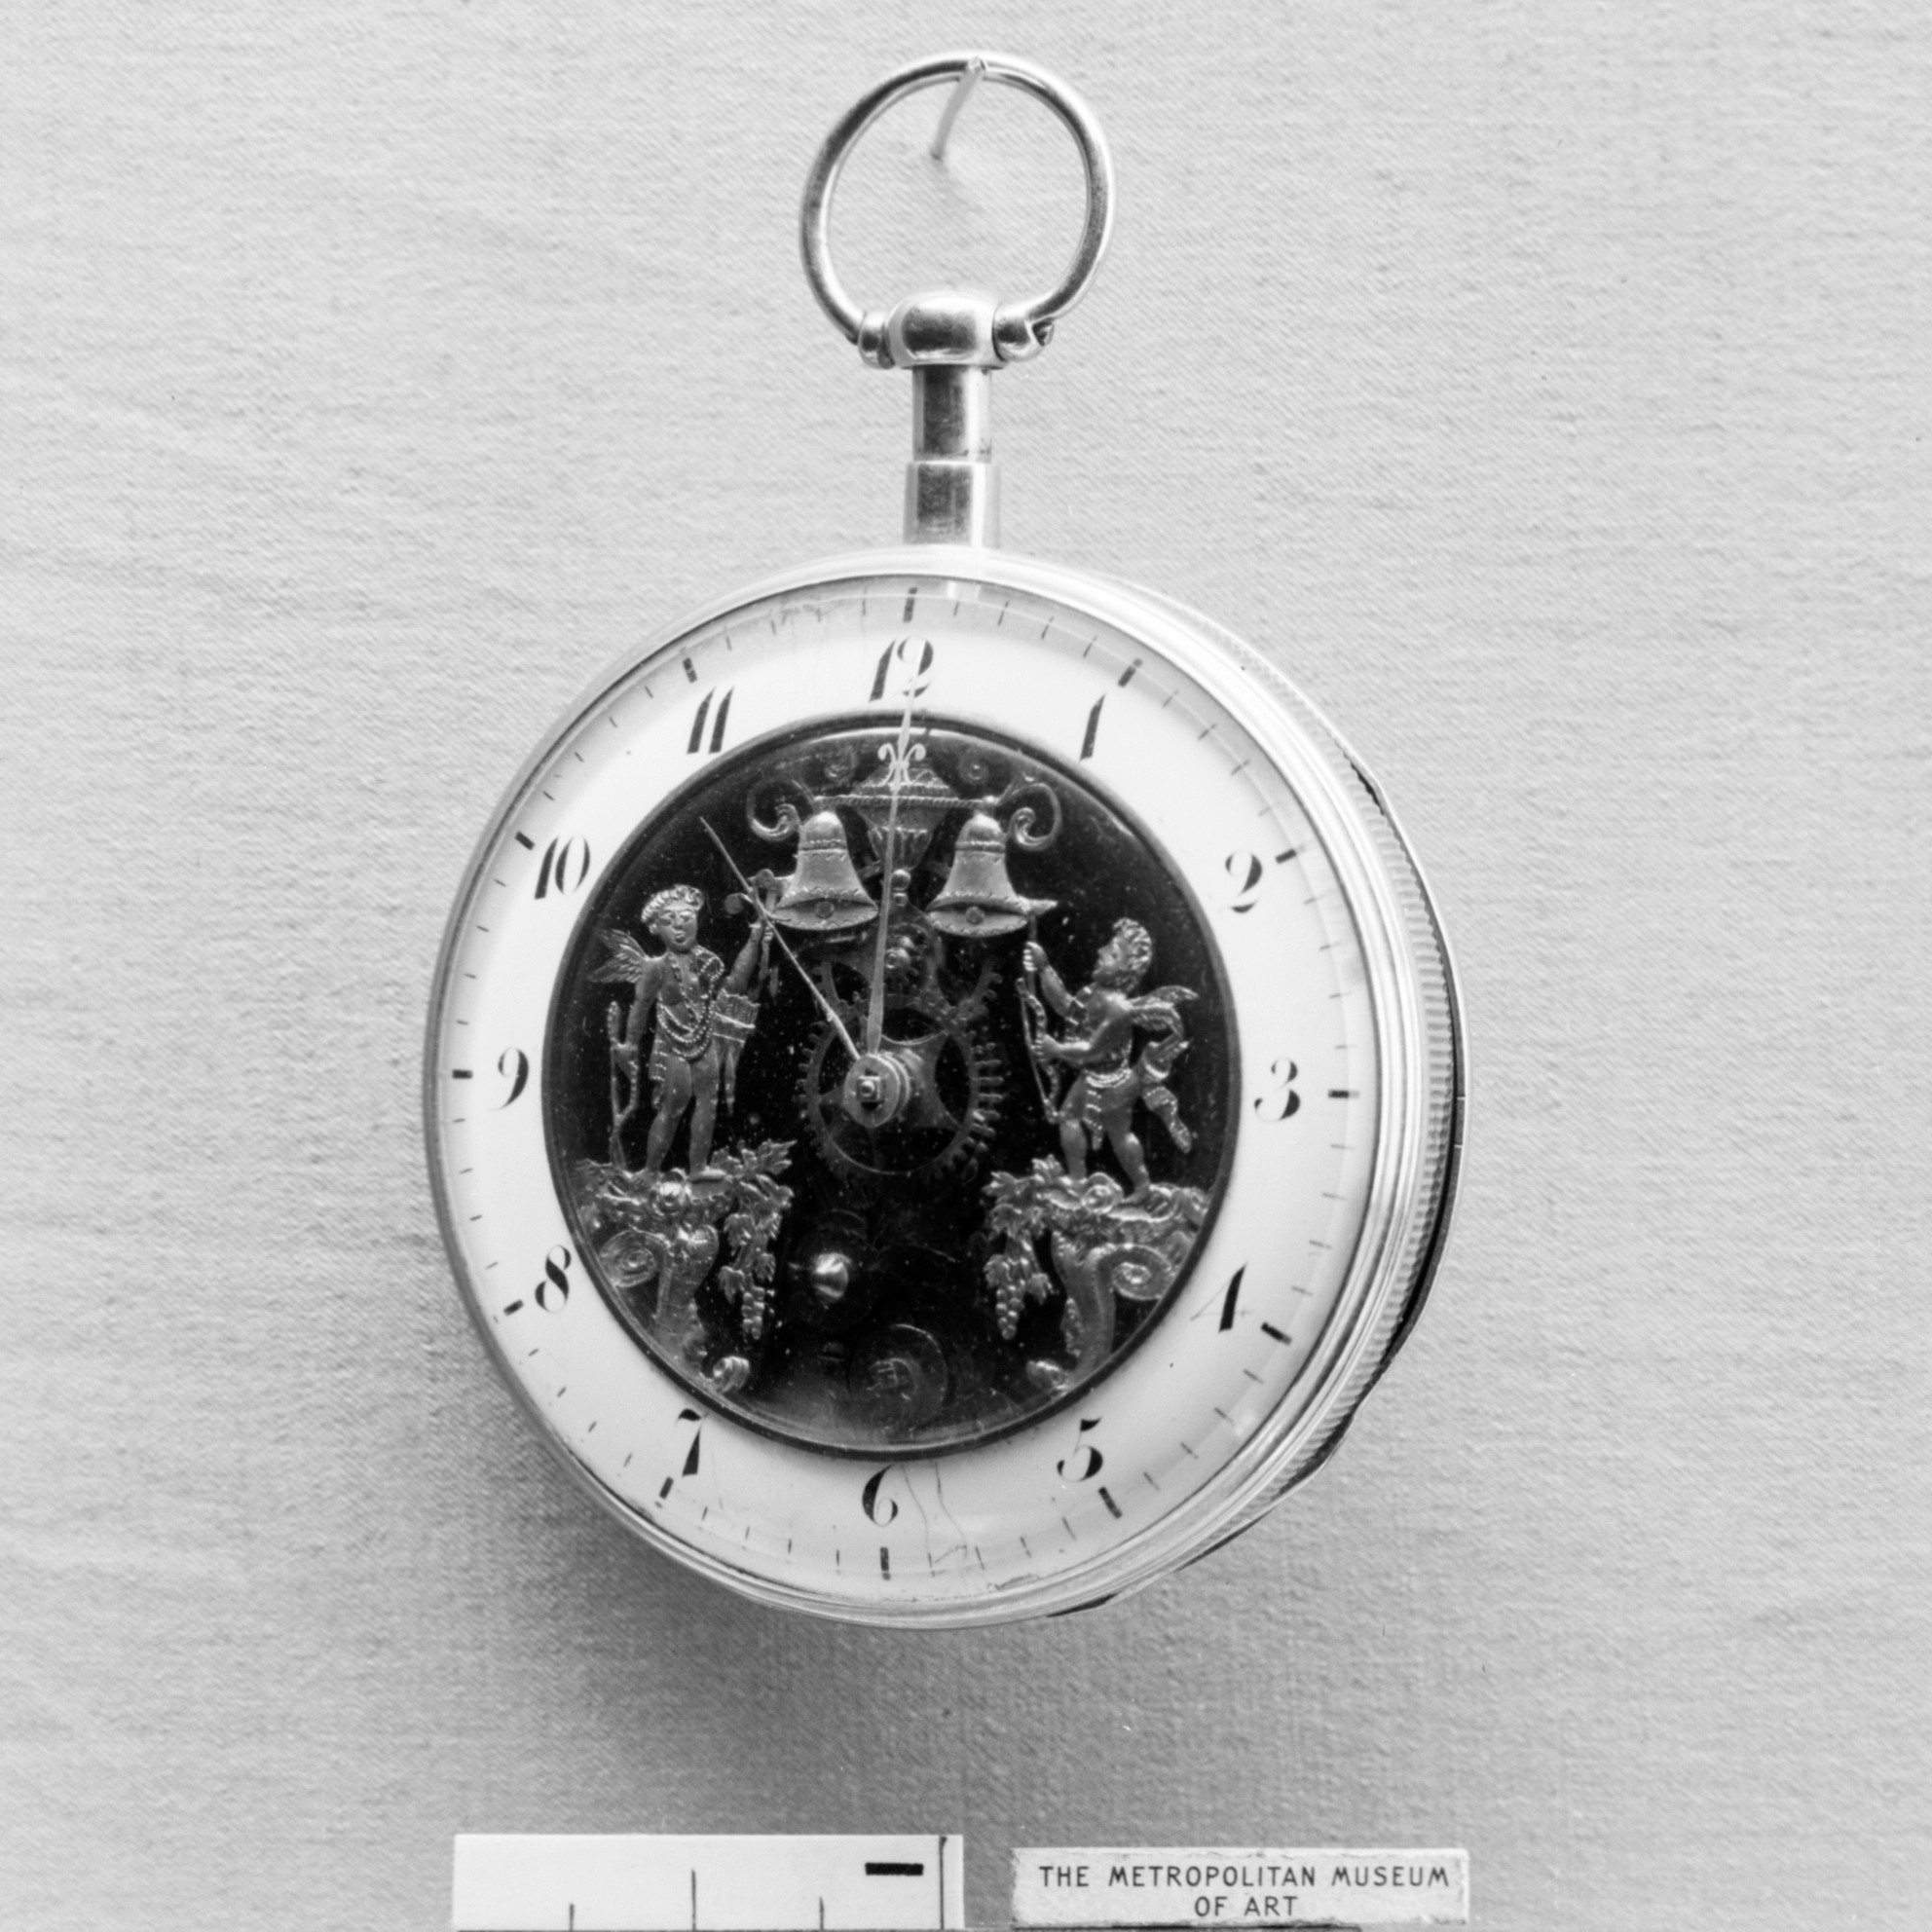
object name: repeater pocket watch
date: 1801-1833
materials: enamel, gold, silver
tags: angels